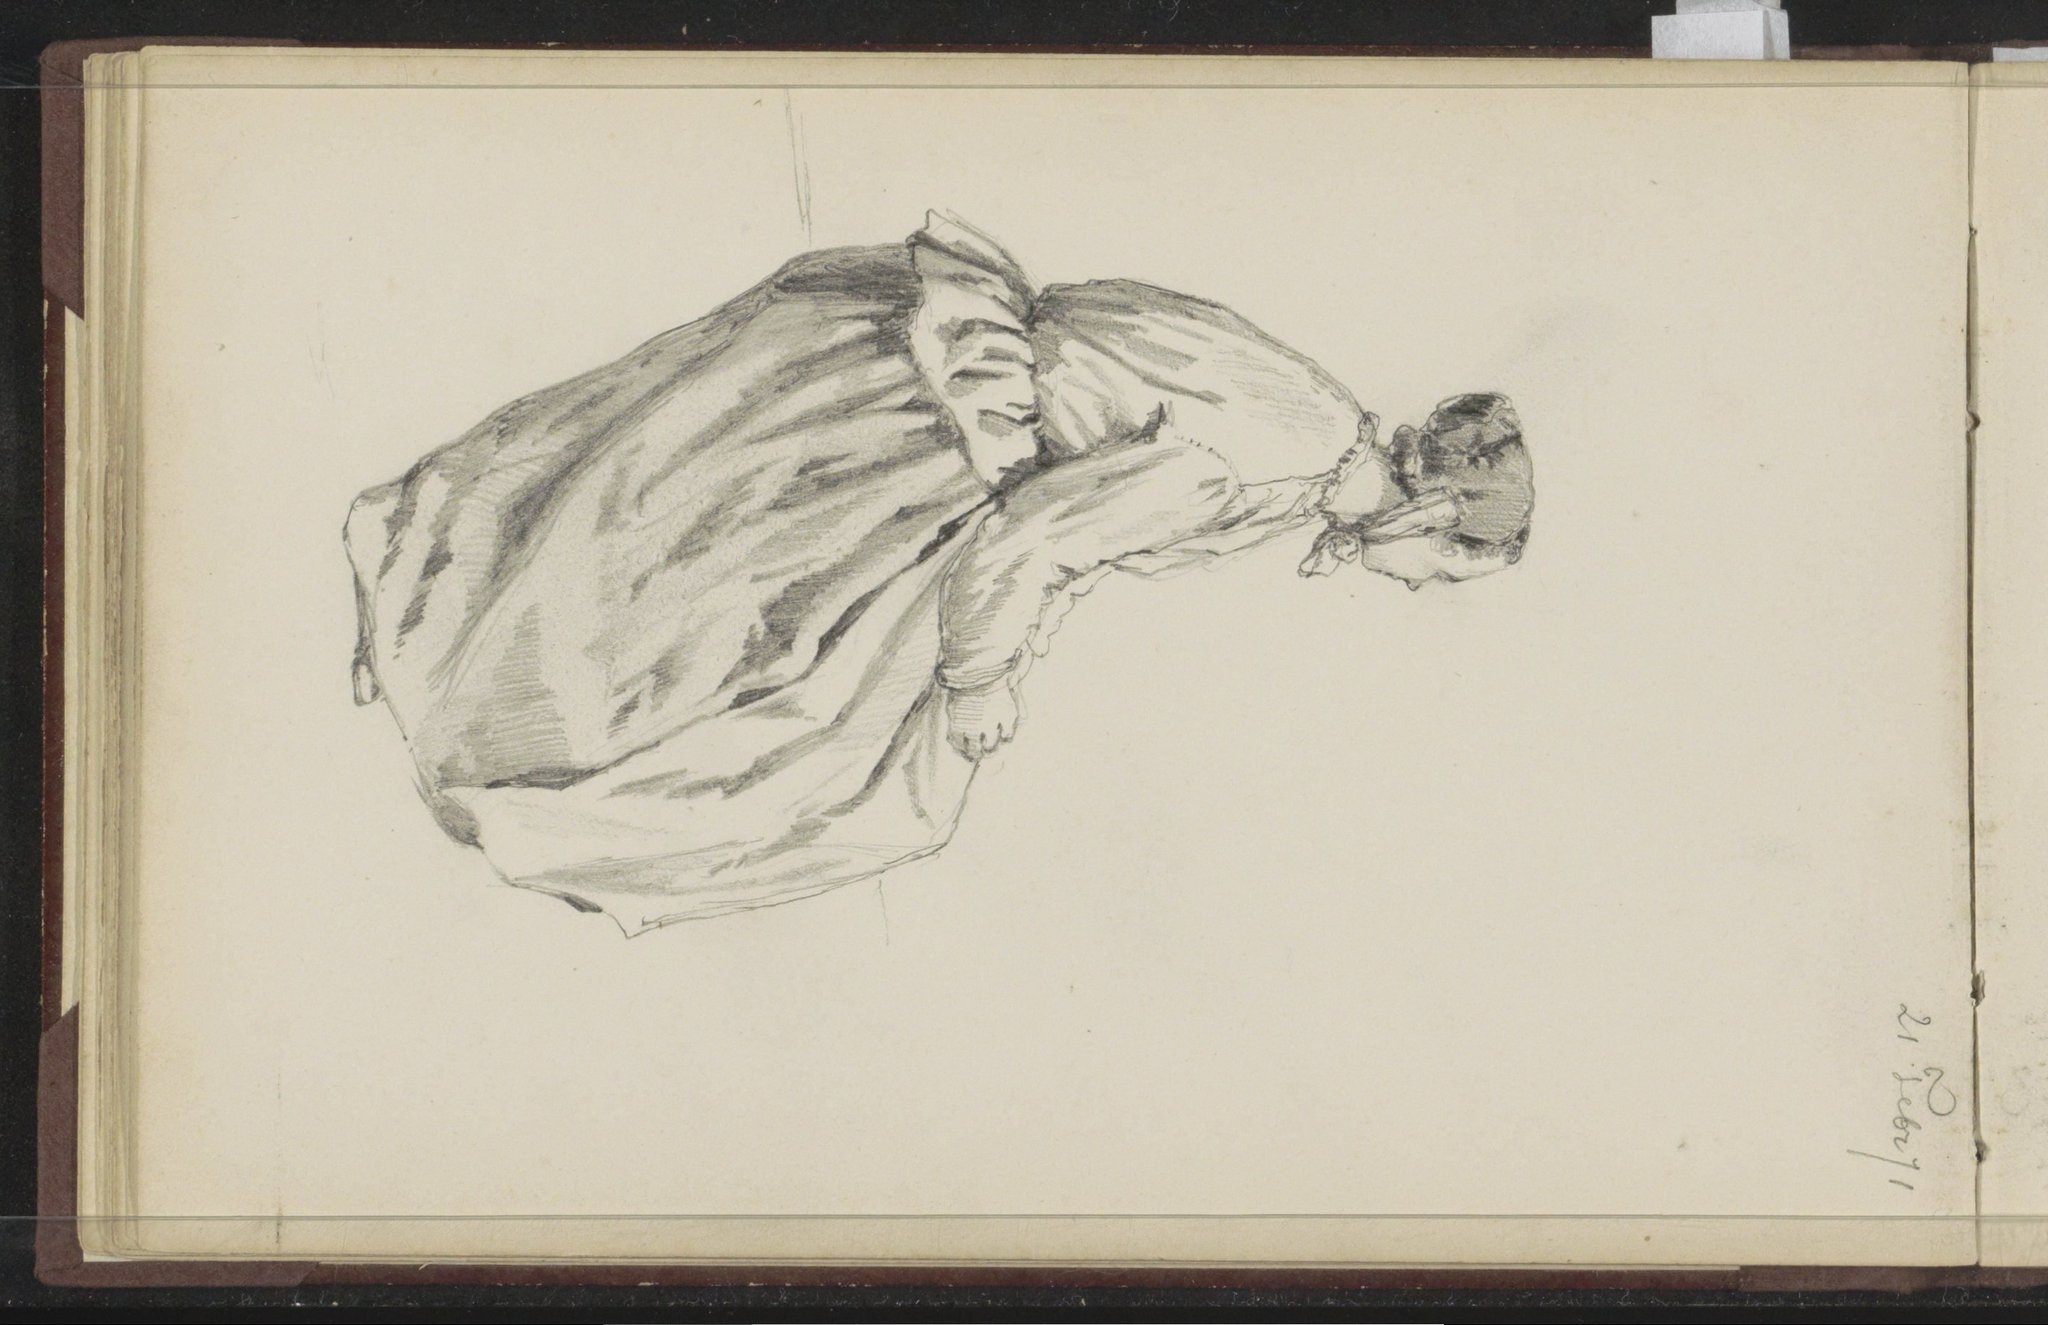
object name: sketchbook leaf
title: Zittende vrouw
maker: cornelis springer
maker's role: draughtsman, painter, print maker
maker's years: 1817-1891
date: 1871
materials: paper, pencil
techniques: stumping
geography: netherlands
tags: sitting figure - aa - female human figure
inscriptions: date: ‘21 Febr 71’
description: Zittende vrouw, in profiel naar rechts. Blad 11 verso uit een schetsboek met 39 bladen, deels vervaardigd te Ulm en Leiden.